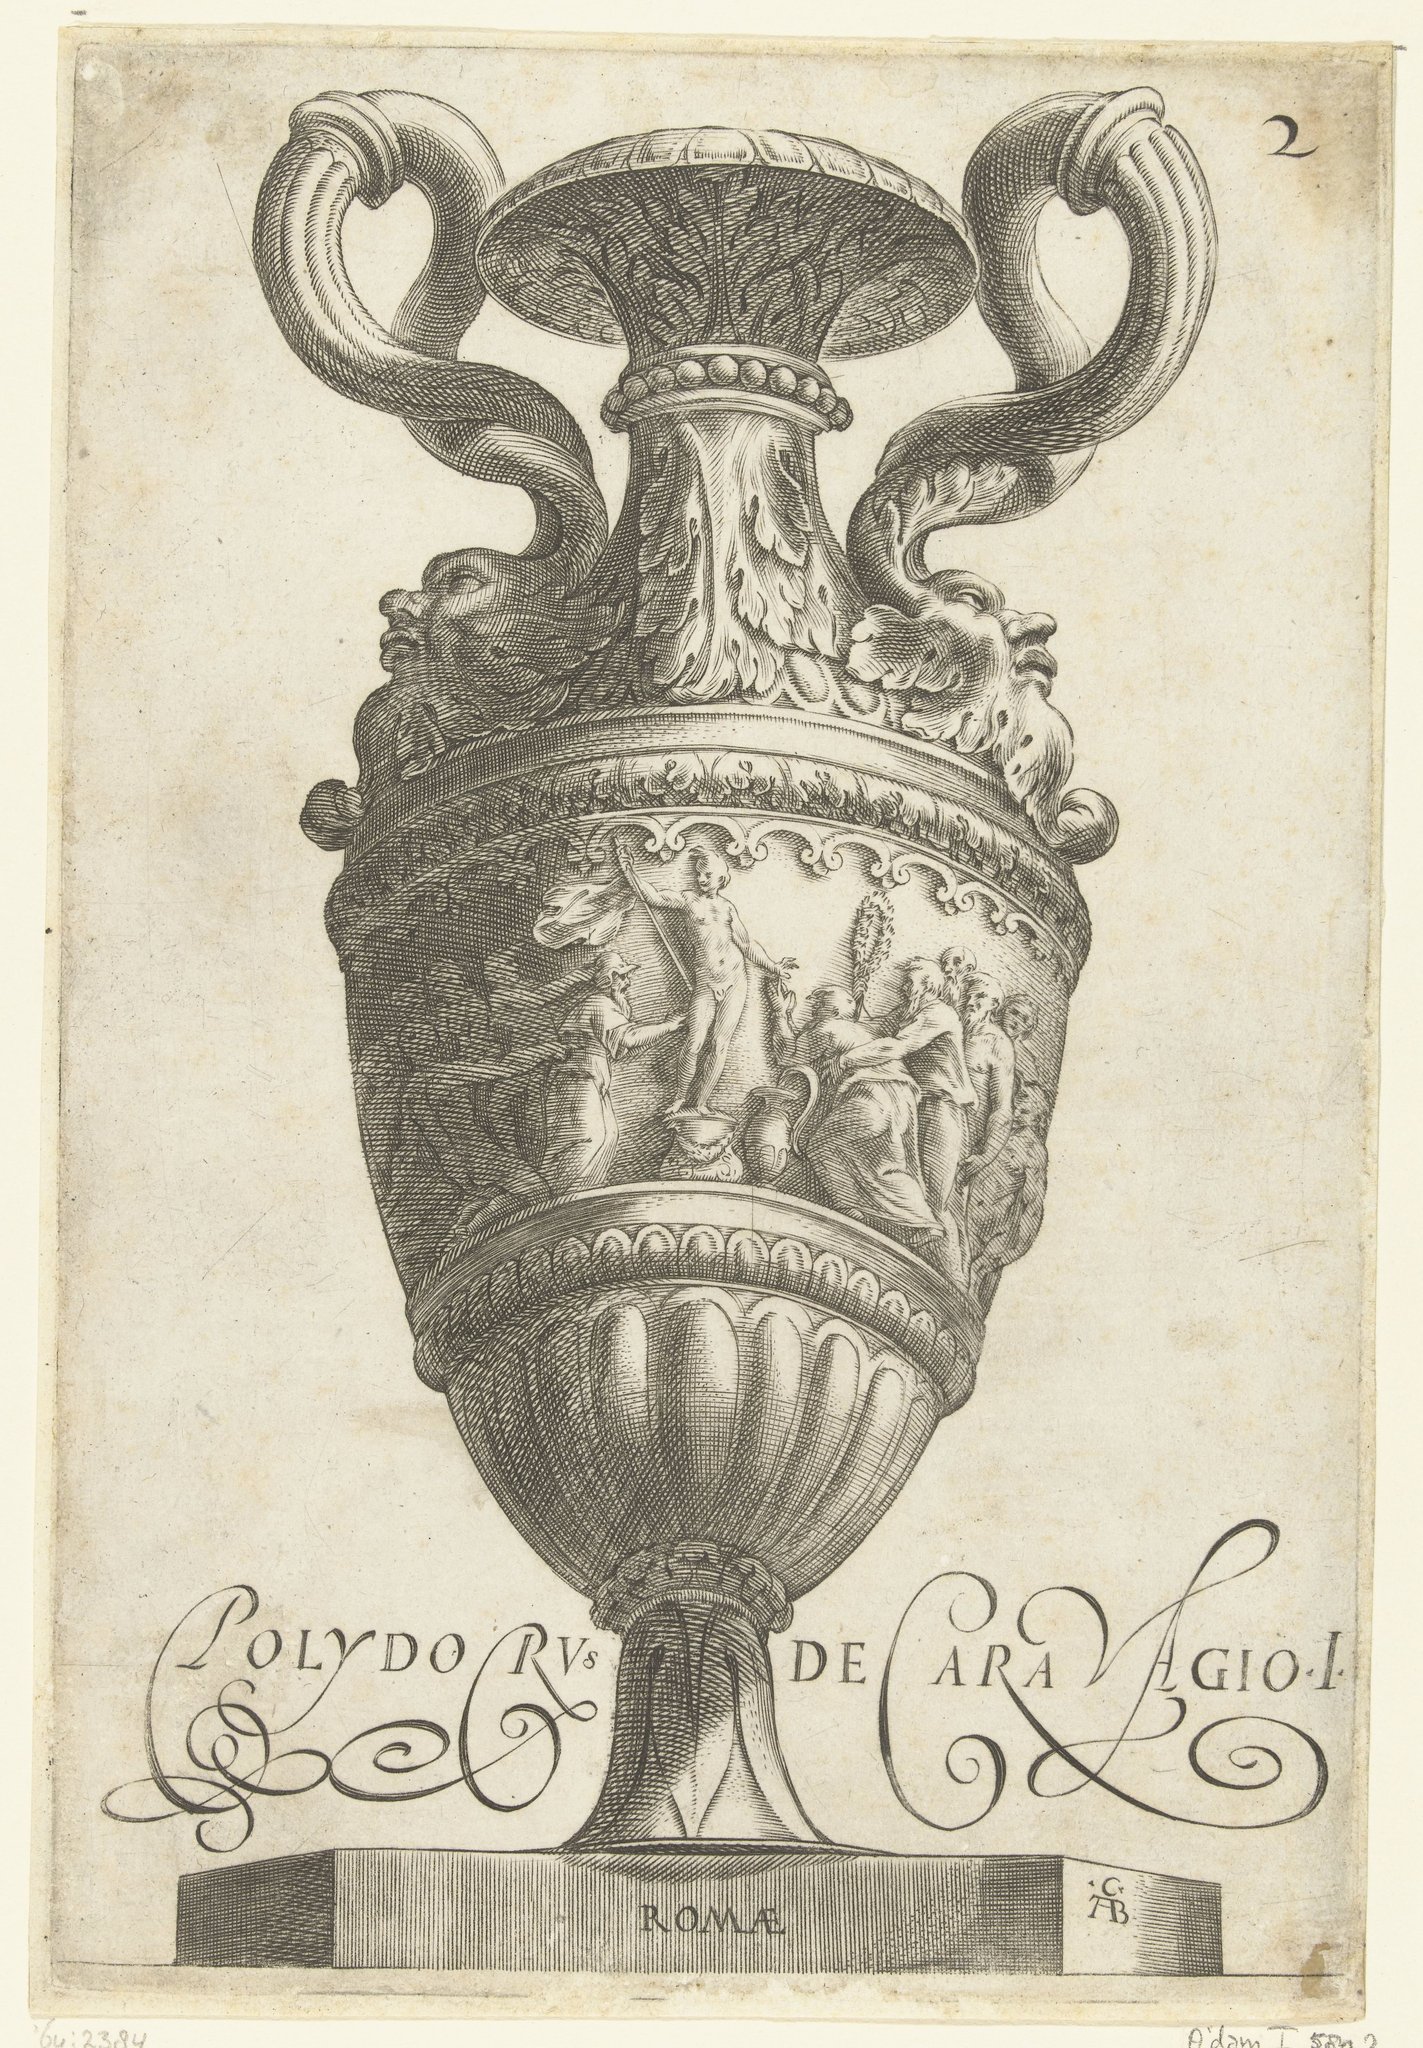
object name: ornament print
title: Vaas met twee gedraaide oren, beginnend en eindigend in eenzelfde mascaron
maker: cherubino alberti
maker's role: draughtsman, print maker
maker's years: 1553-1615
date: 1563-1582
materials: paper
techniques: engraving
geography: italy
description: De buik is gedecoreerd met een fries waarop twee groepen mensen een in het midden staande godheid aanbidden. Uit serie van 10 bladen.